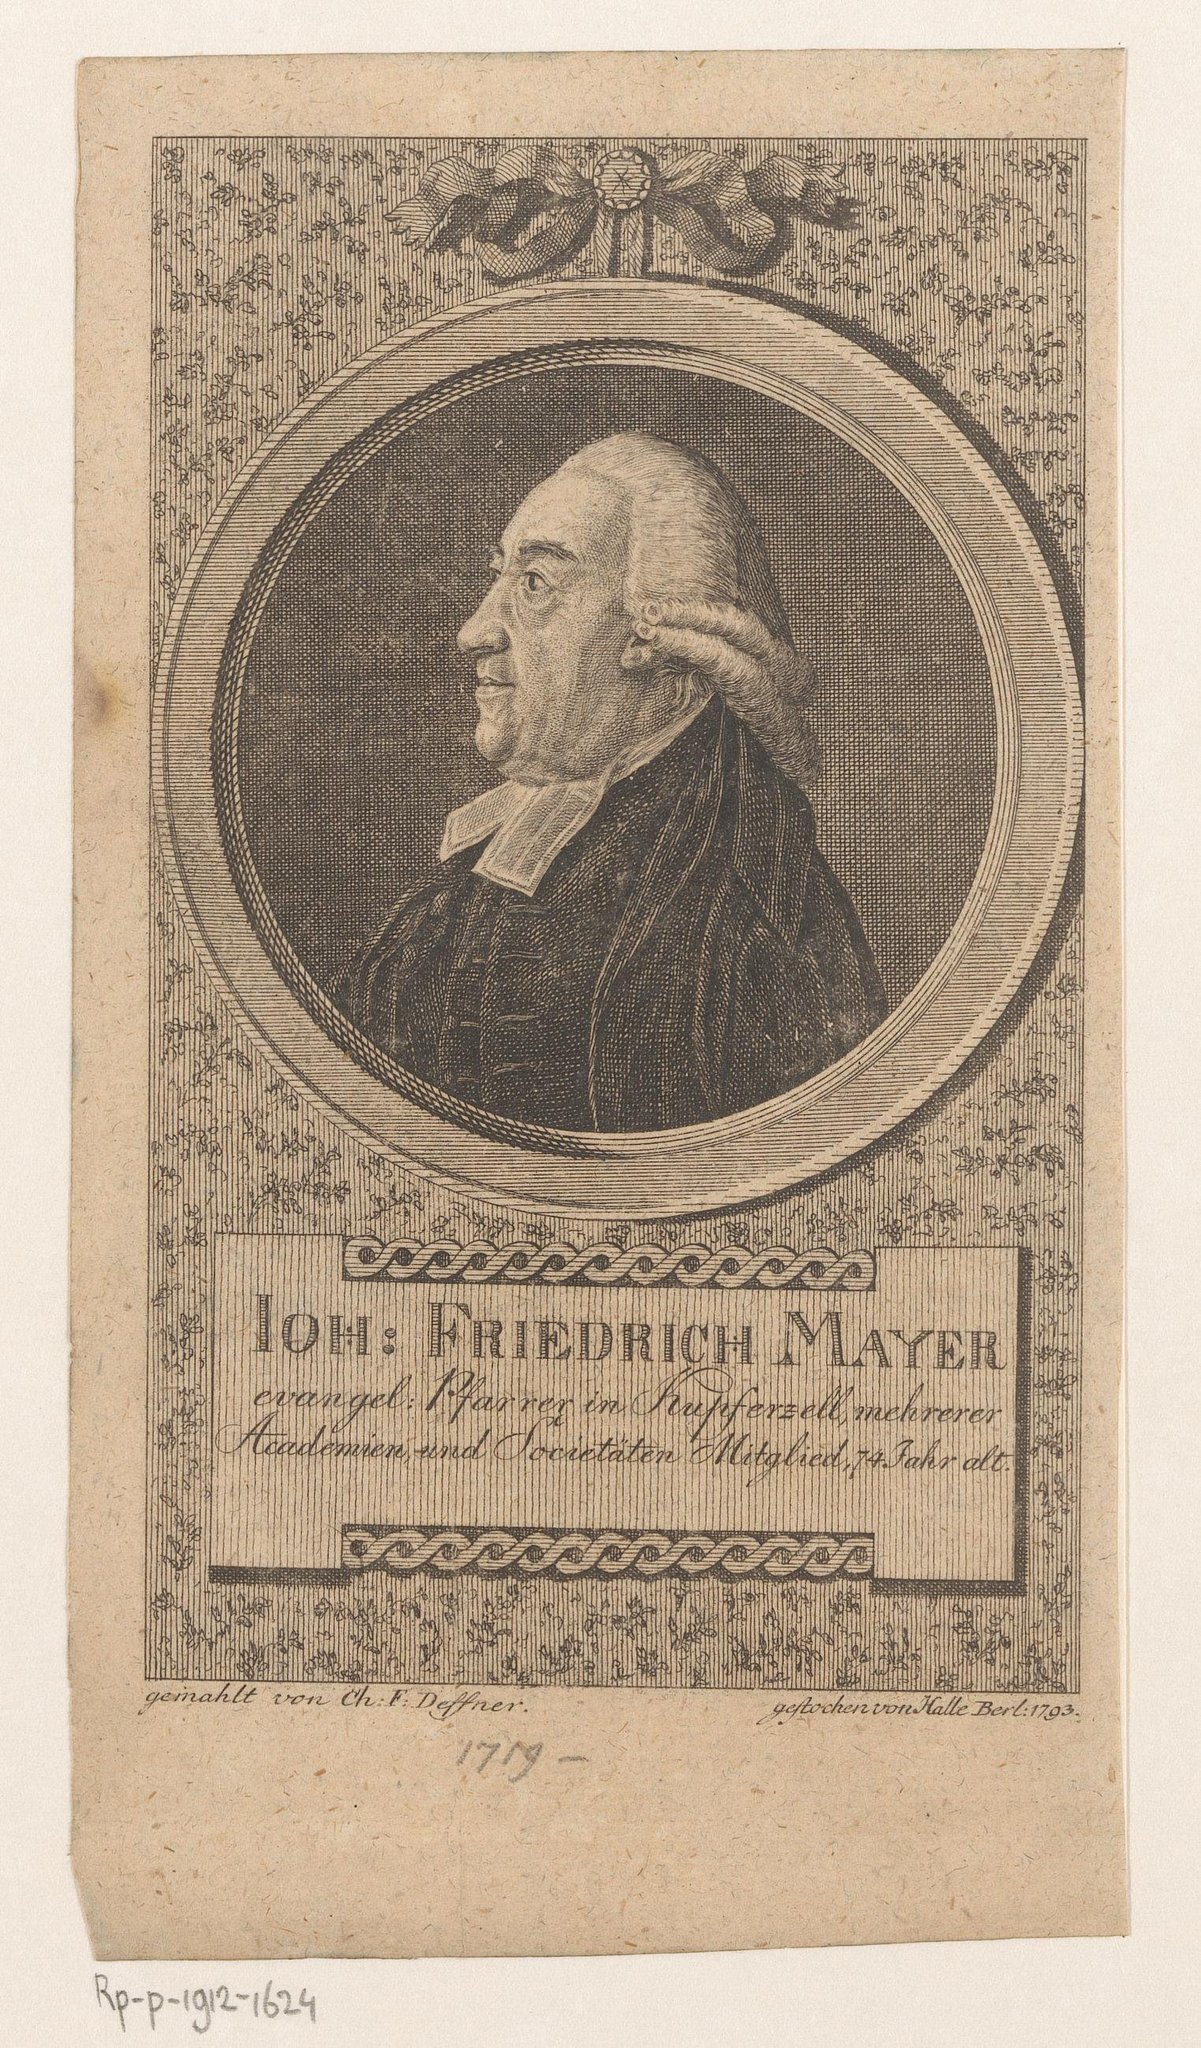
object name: print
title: Portret van Johann Friedrich Mayer op 74-jarige leeftijd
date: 1793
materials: paper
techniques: engraving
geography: berlin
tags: ornament ~ medallion, historical persons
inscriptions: collector's mark: Lugt 2228